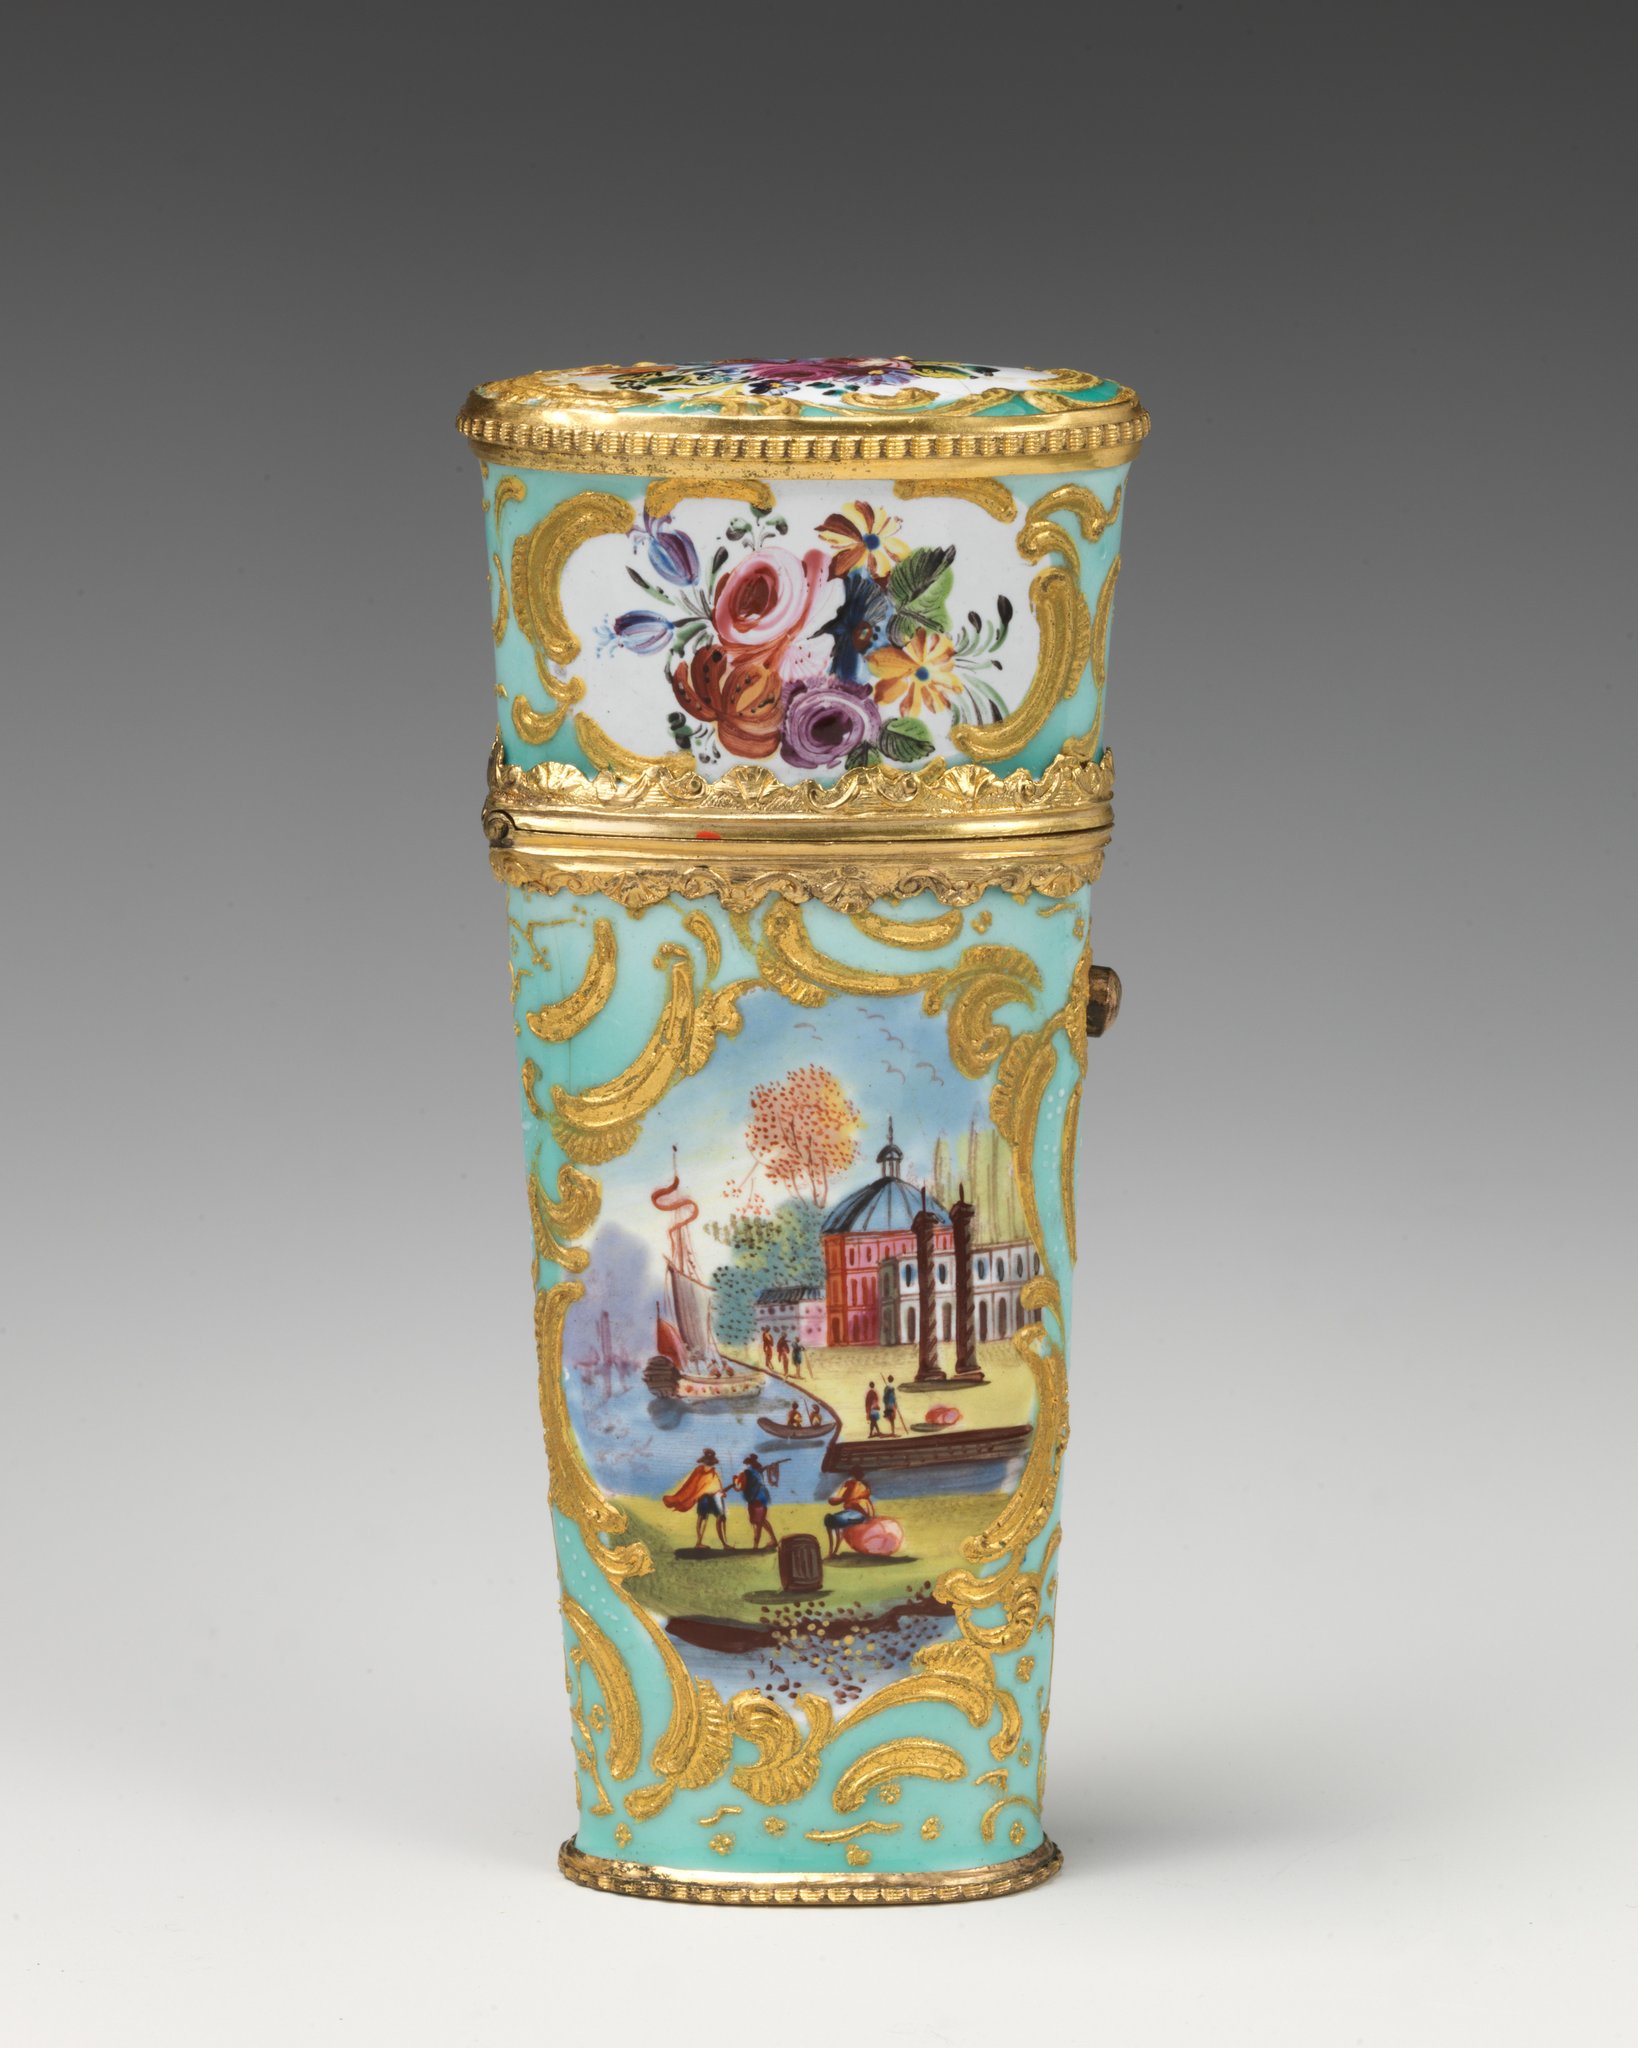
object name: étui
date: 1765-1770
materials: copper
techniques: enamel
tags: buildings,flowers,ships